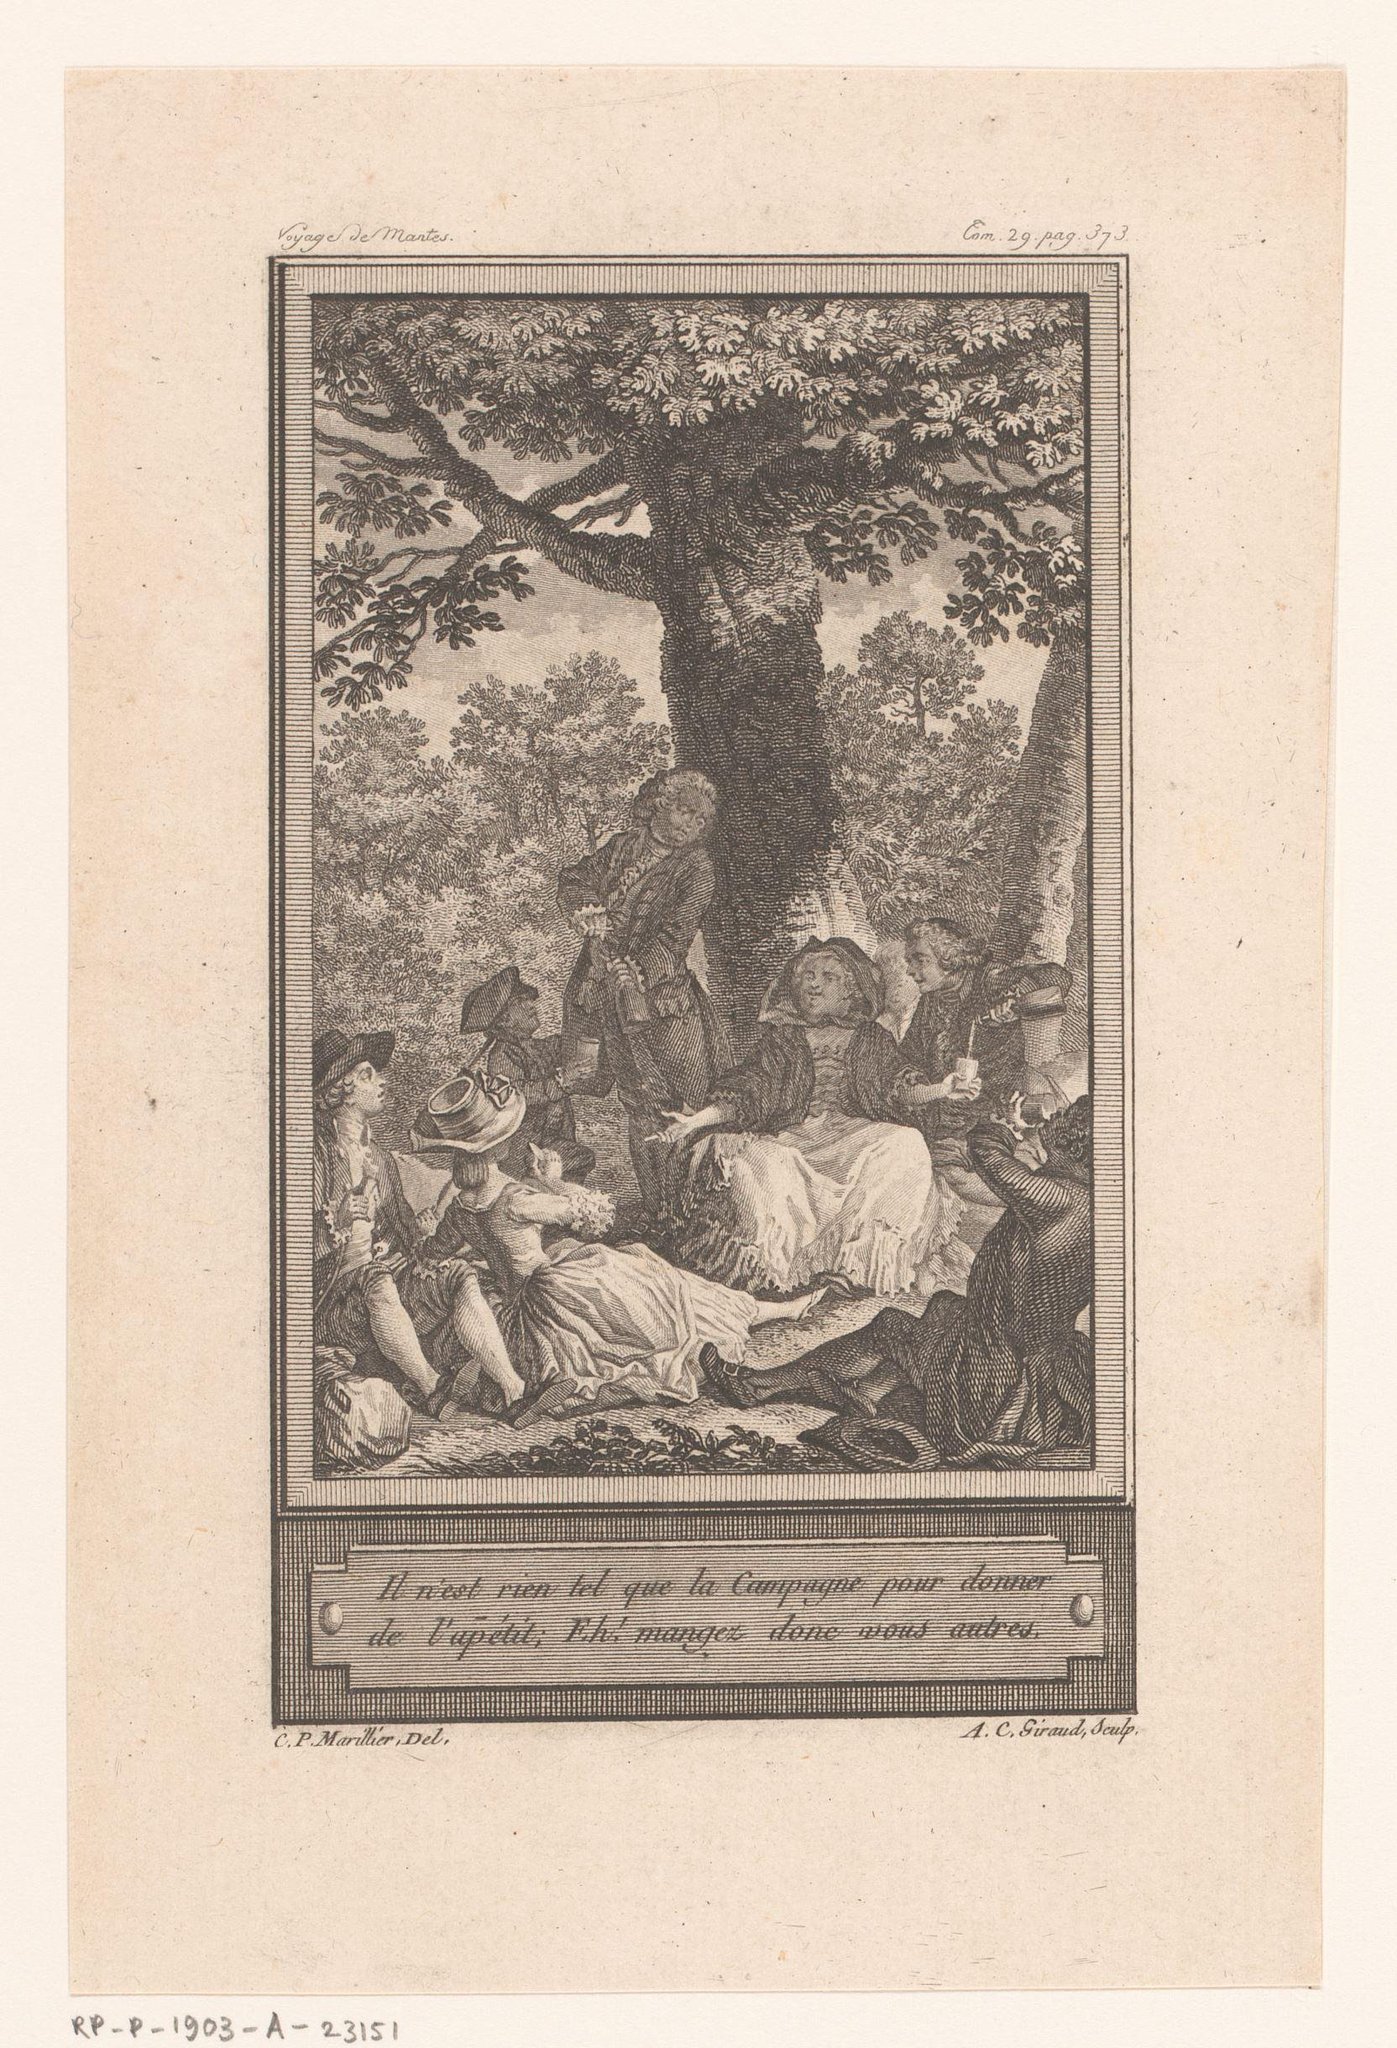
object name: book illustration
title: Drinkend gezelschap onder een boom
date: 1788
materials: paper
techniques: etching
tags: drinking, private festivities, merry company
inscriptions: collector's mark: Lugt 2228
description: Prent uit: Gimat de Bonneval, Jean-Baptiste. Le voyage de Mantes. Amsterdam en Parijs: s.n., 1788. Dit betreft dl. 29, p. 373 uit Les songes et visions philosophiques.